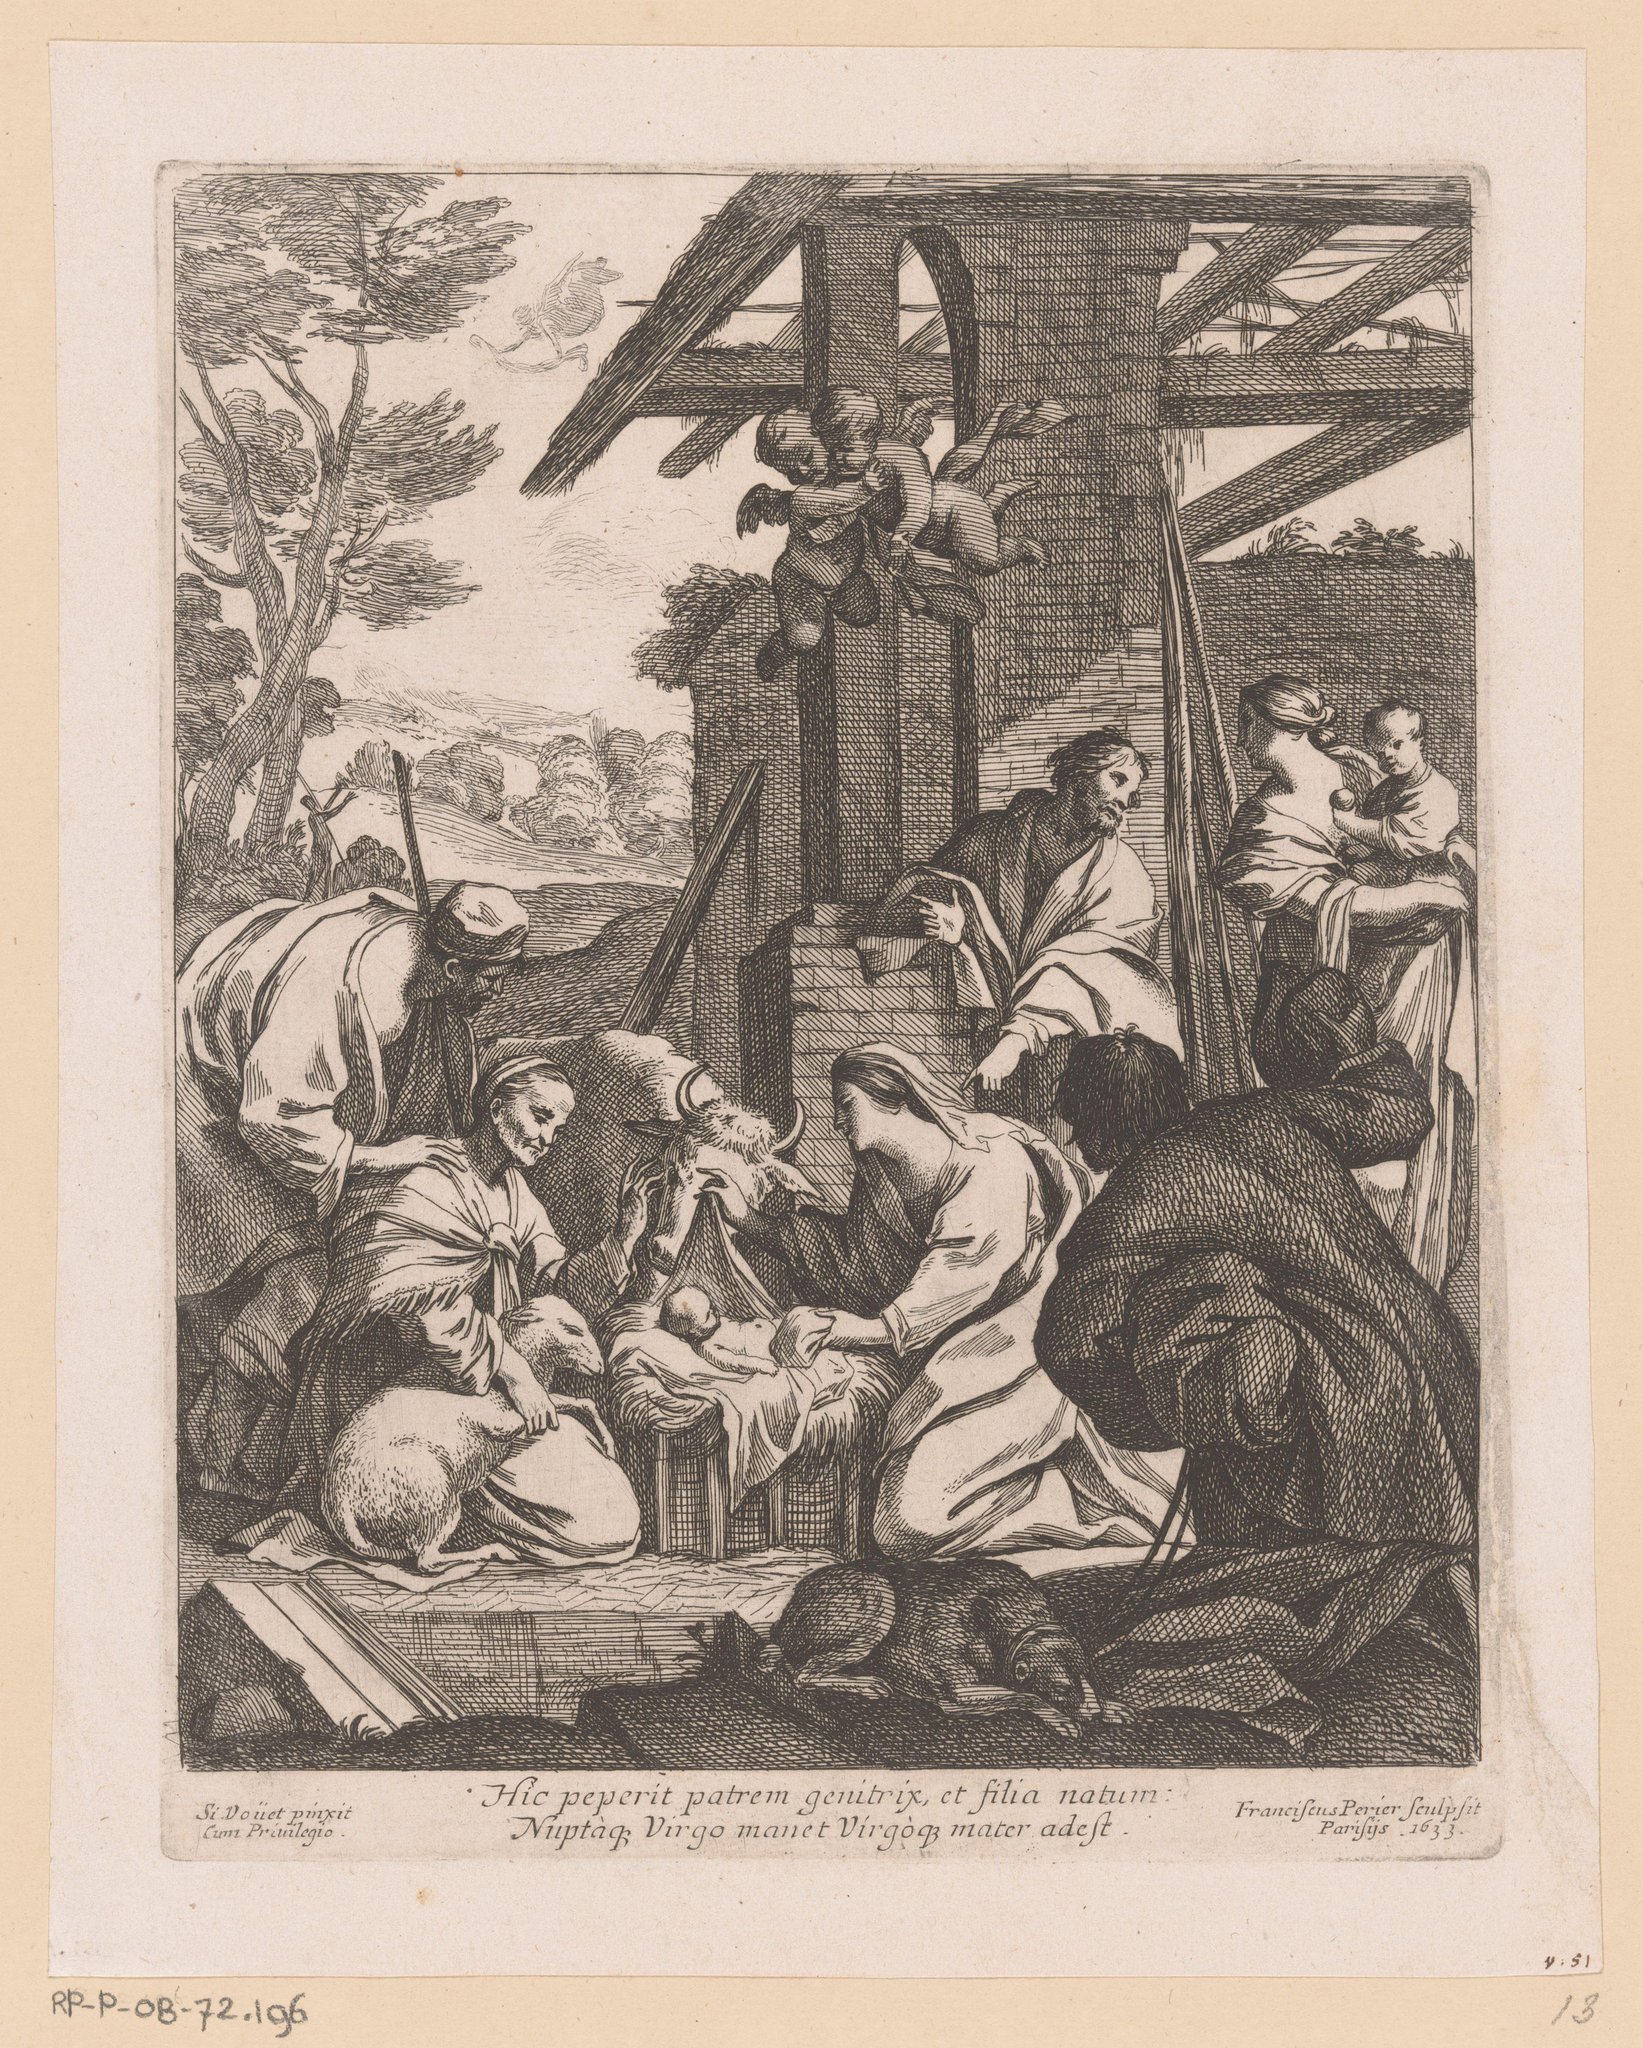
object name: print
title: Hic peperit patrem genitrix (...)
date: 1633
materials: paper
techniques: etching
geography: france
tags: christ-child in the manger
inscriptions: collector's mark: Lugt 240